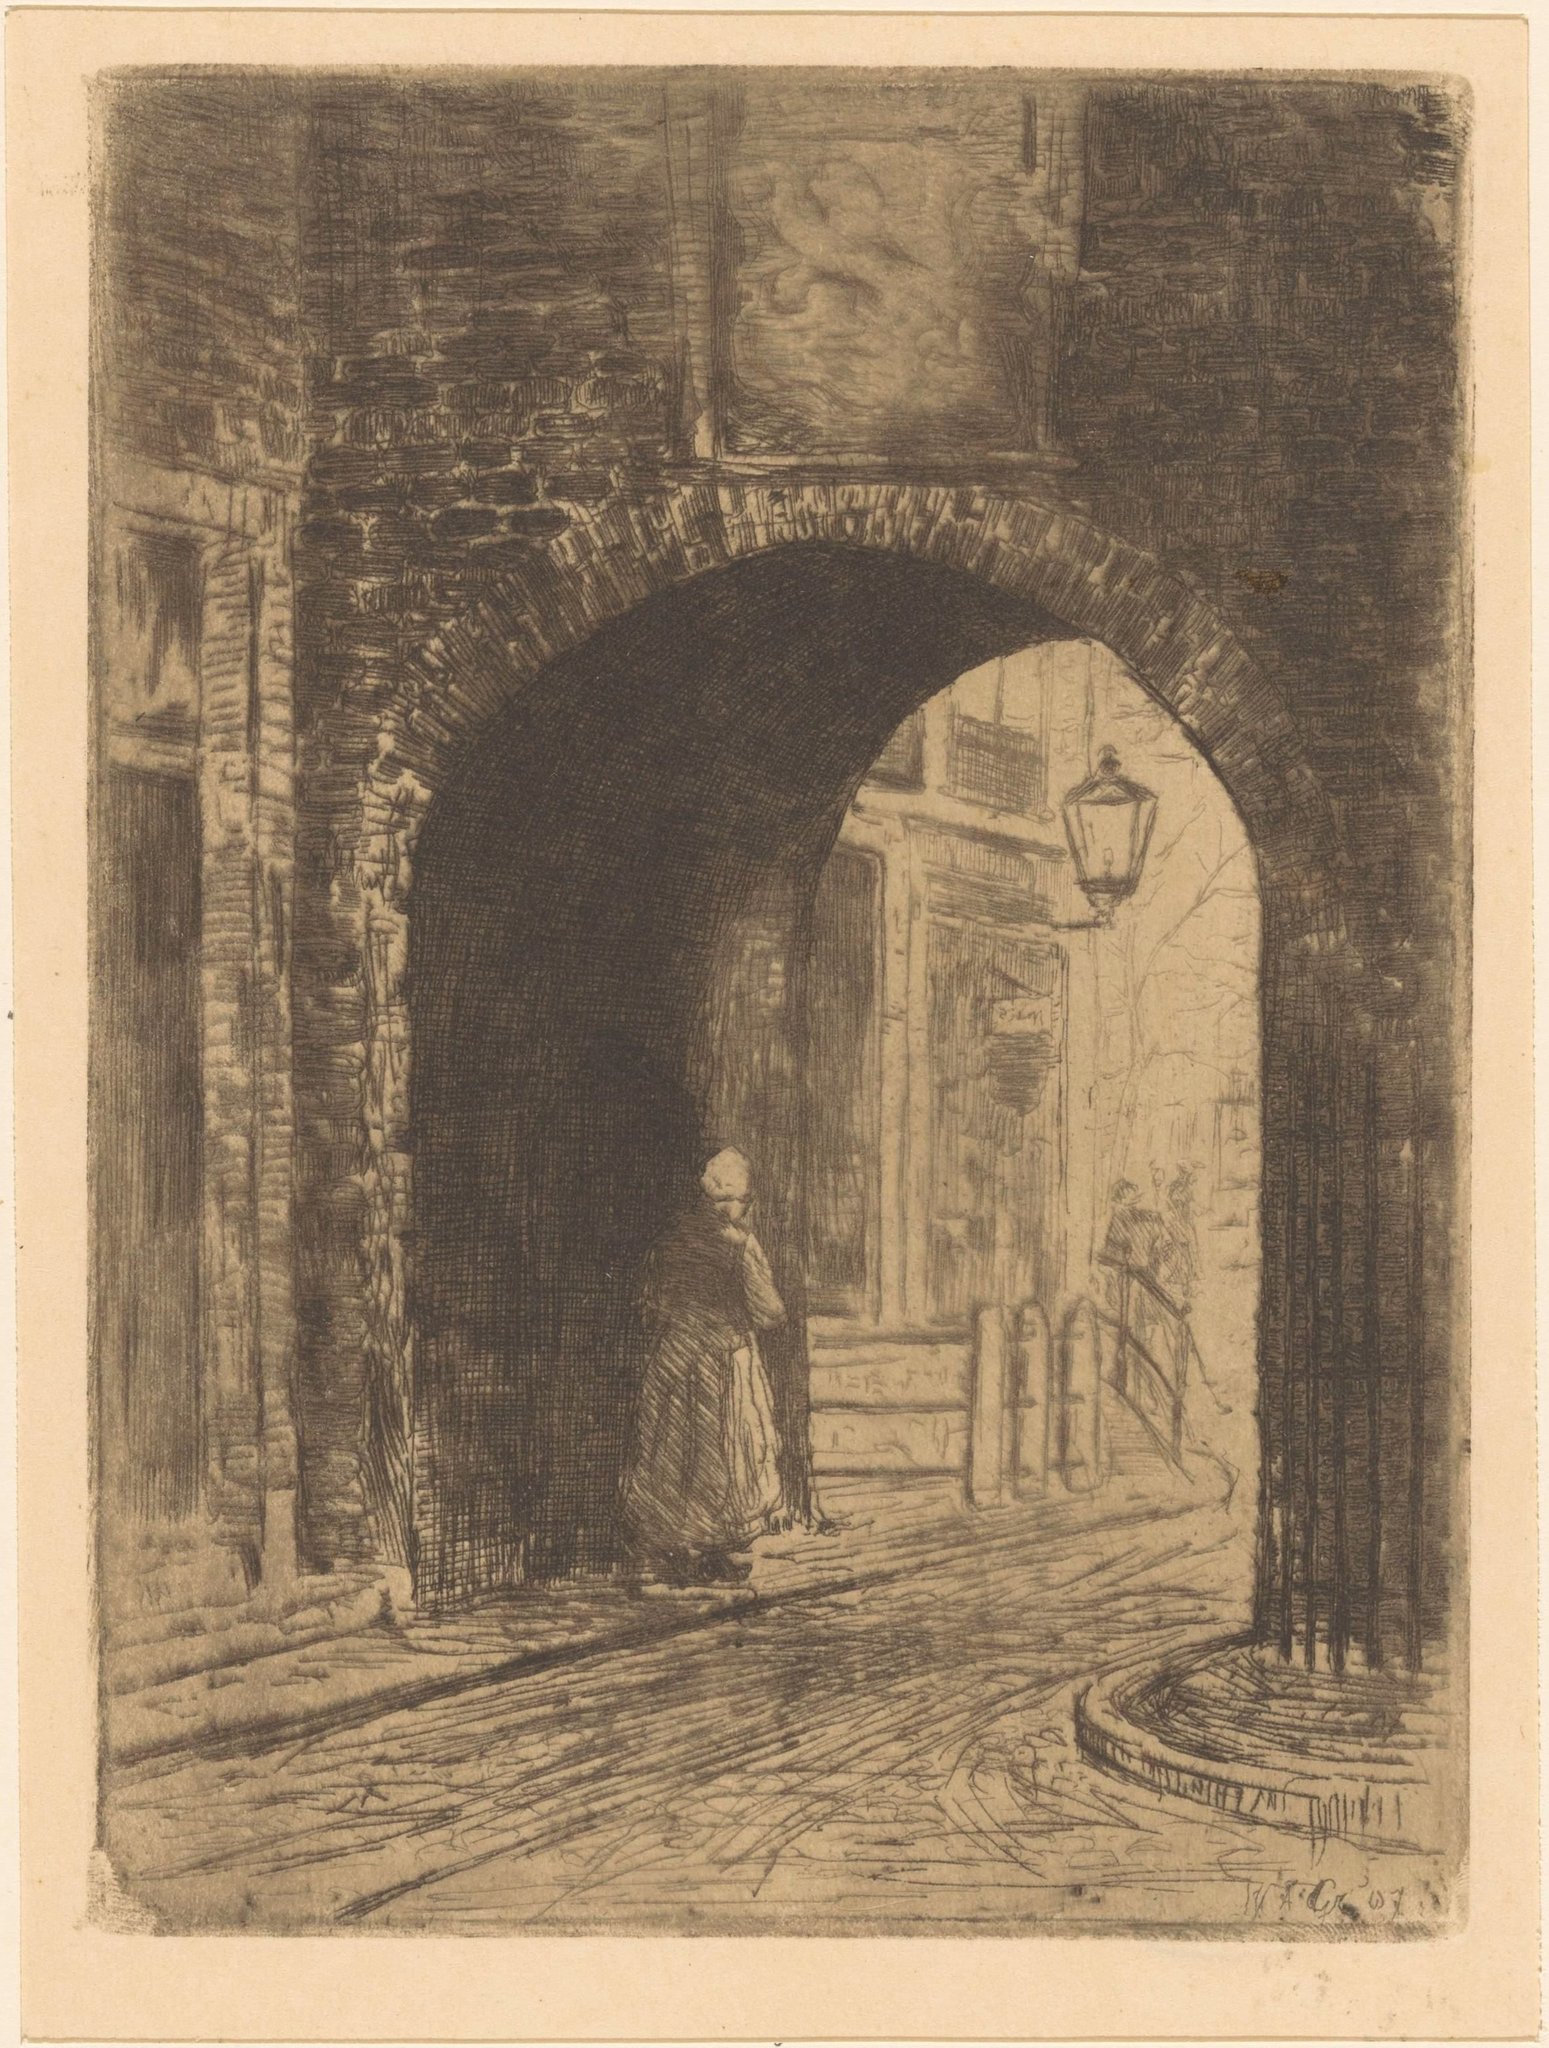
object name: print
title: Gevangenpoort in Den Haag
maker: willem adrianus grondhout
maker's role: draughtsman, painter, print maker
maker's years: 1878-1934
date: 1907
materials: paper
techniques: etching, intaglio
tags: prison, jail, gate, entrance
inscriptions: collector's mark: Lugt 2228